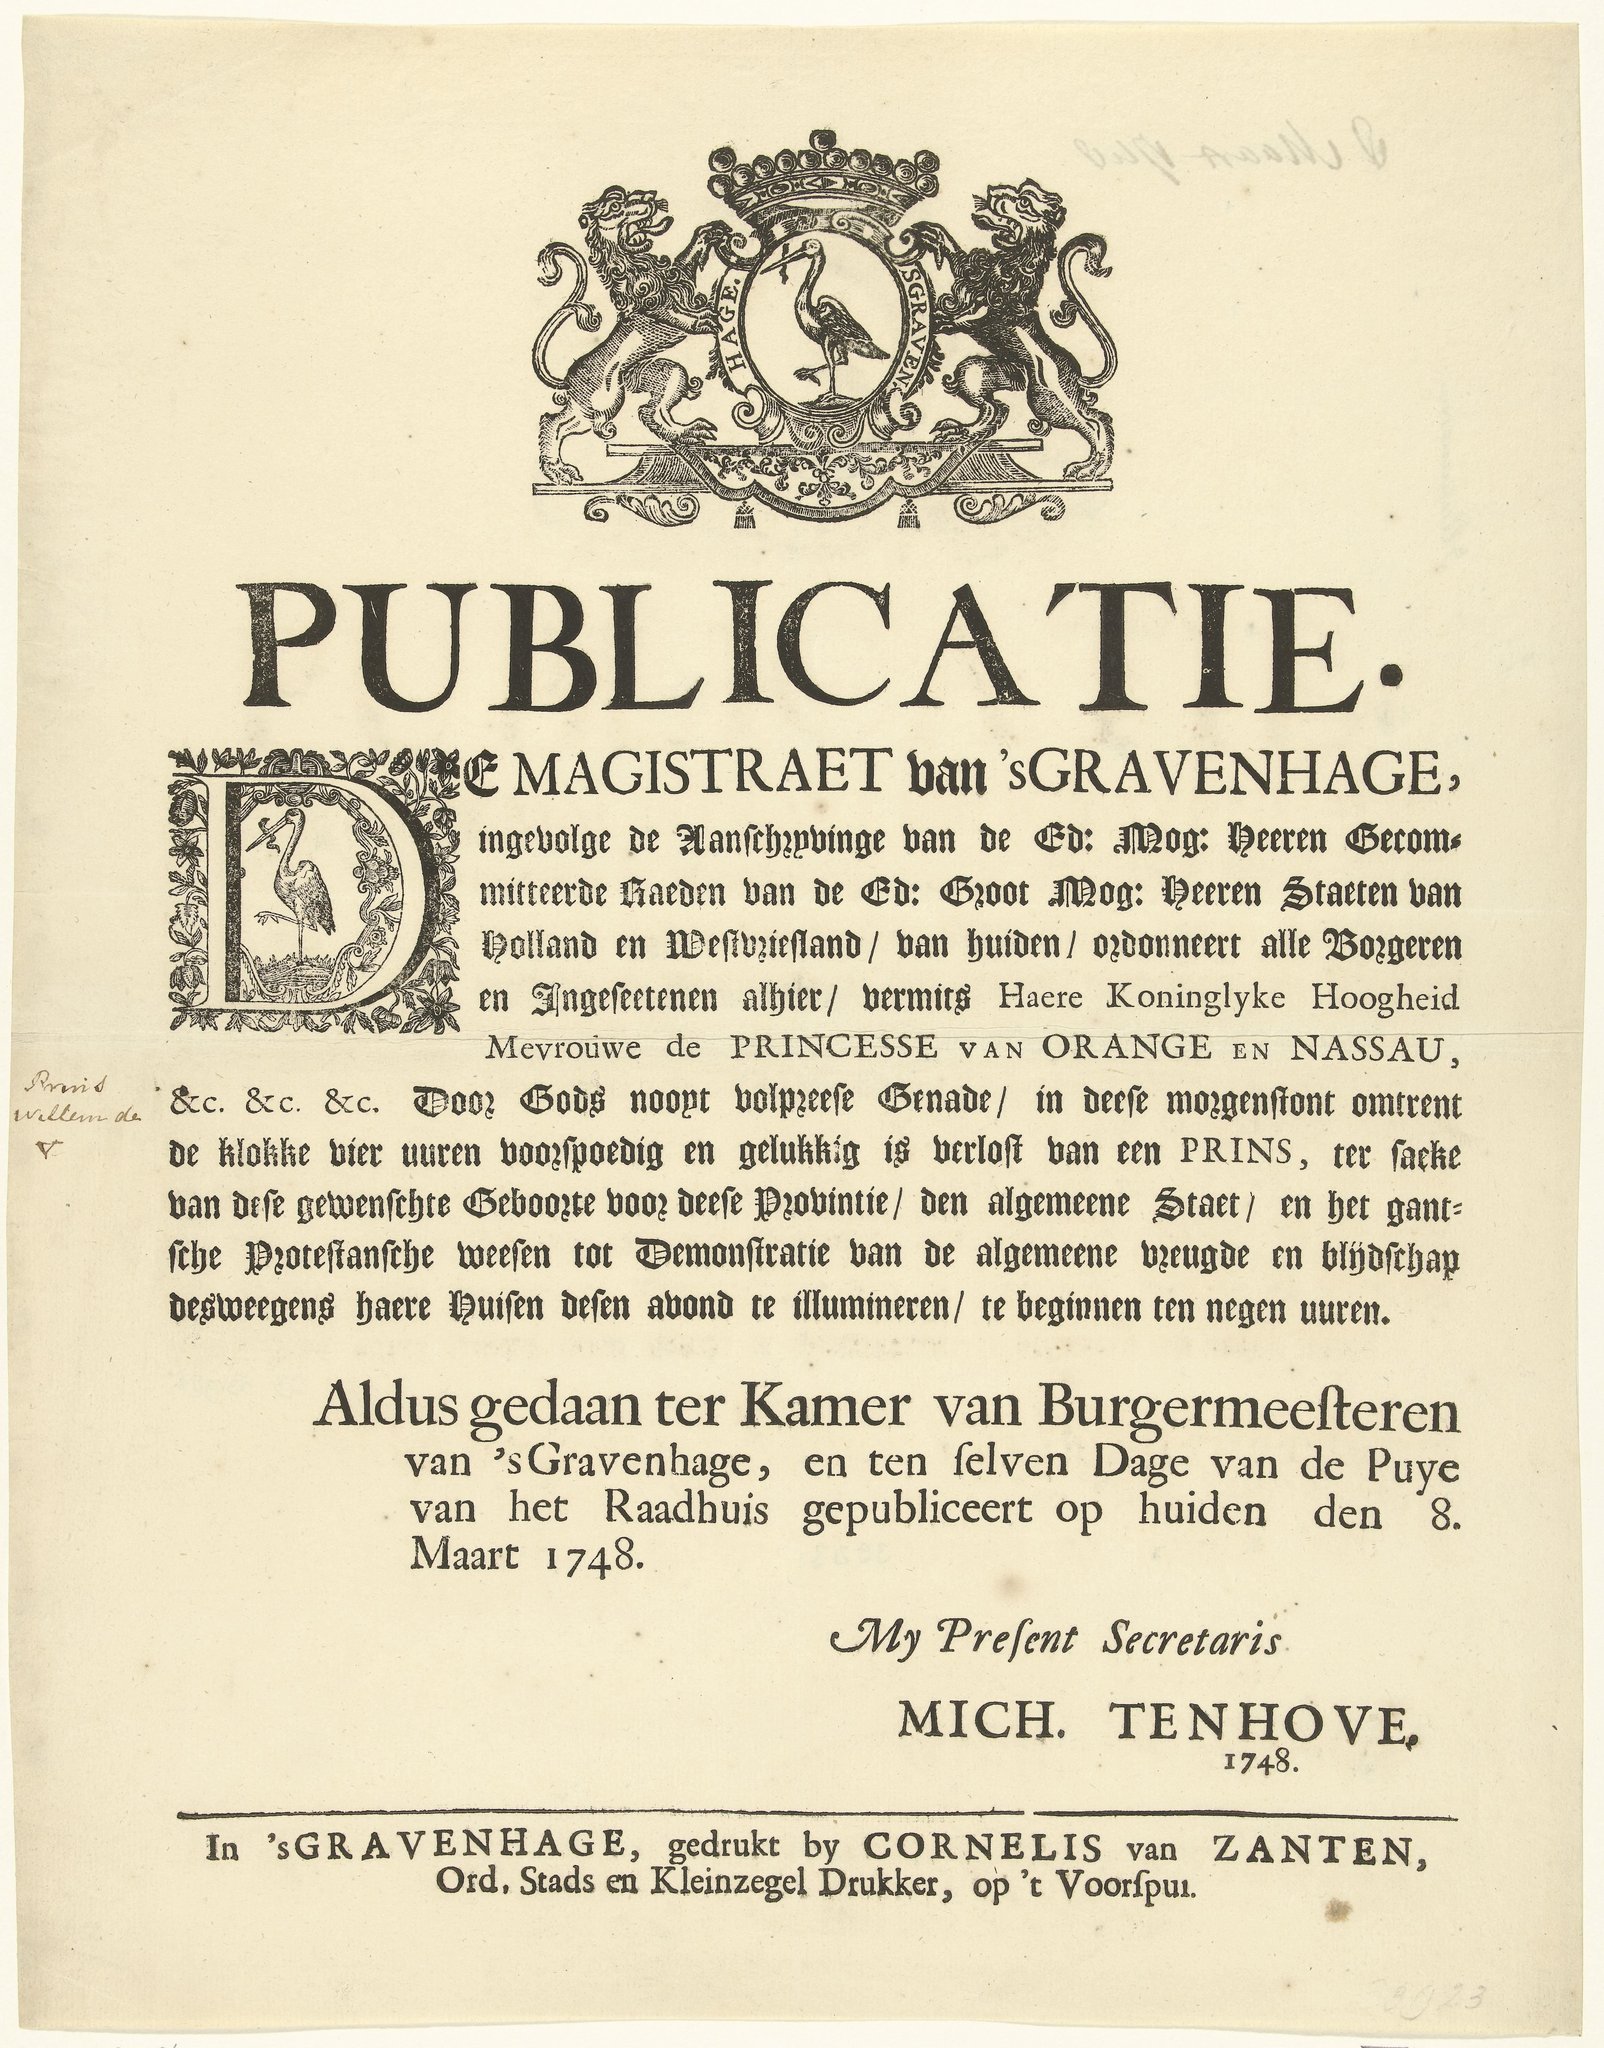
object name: text sheet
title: Toestemming tot illuminatie bij de geboorte van prins Willem V, 1748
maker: cornelis van zanten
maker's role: publisher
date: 1748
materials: paper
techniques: letterpress printing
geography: the hague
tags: william v (prince of orange), the hague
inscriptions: collector's mark: Lugt 2228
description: Bekendmaking van de verlening van toestemming door het stadsbestuur van Den Haag om te mogen illumineren op 8 maart 1748 ter gelegenheid van de geboorte van prins Willem V. Bovenaan het stadswapen, de tekst begint met een versierde initiaal D.